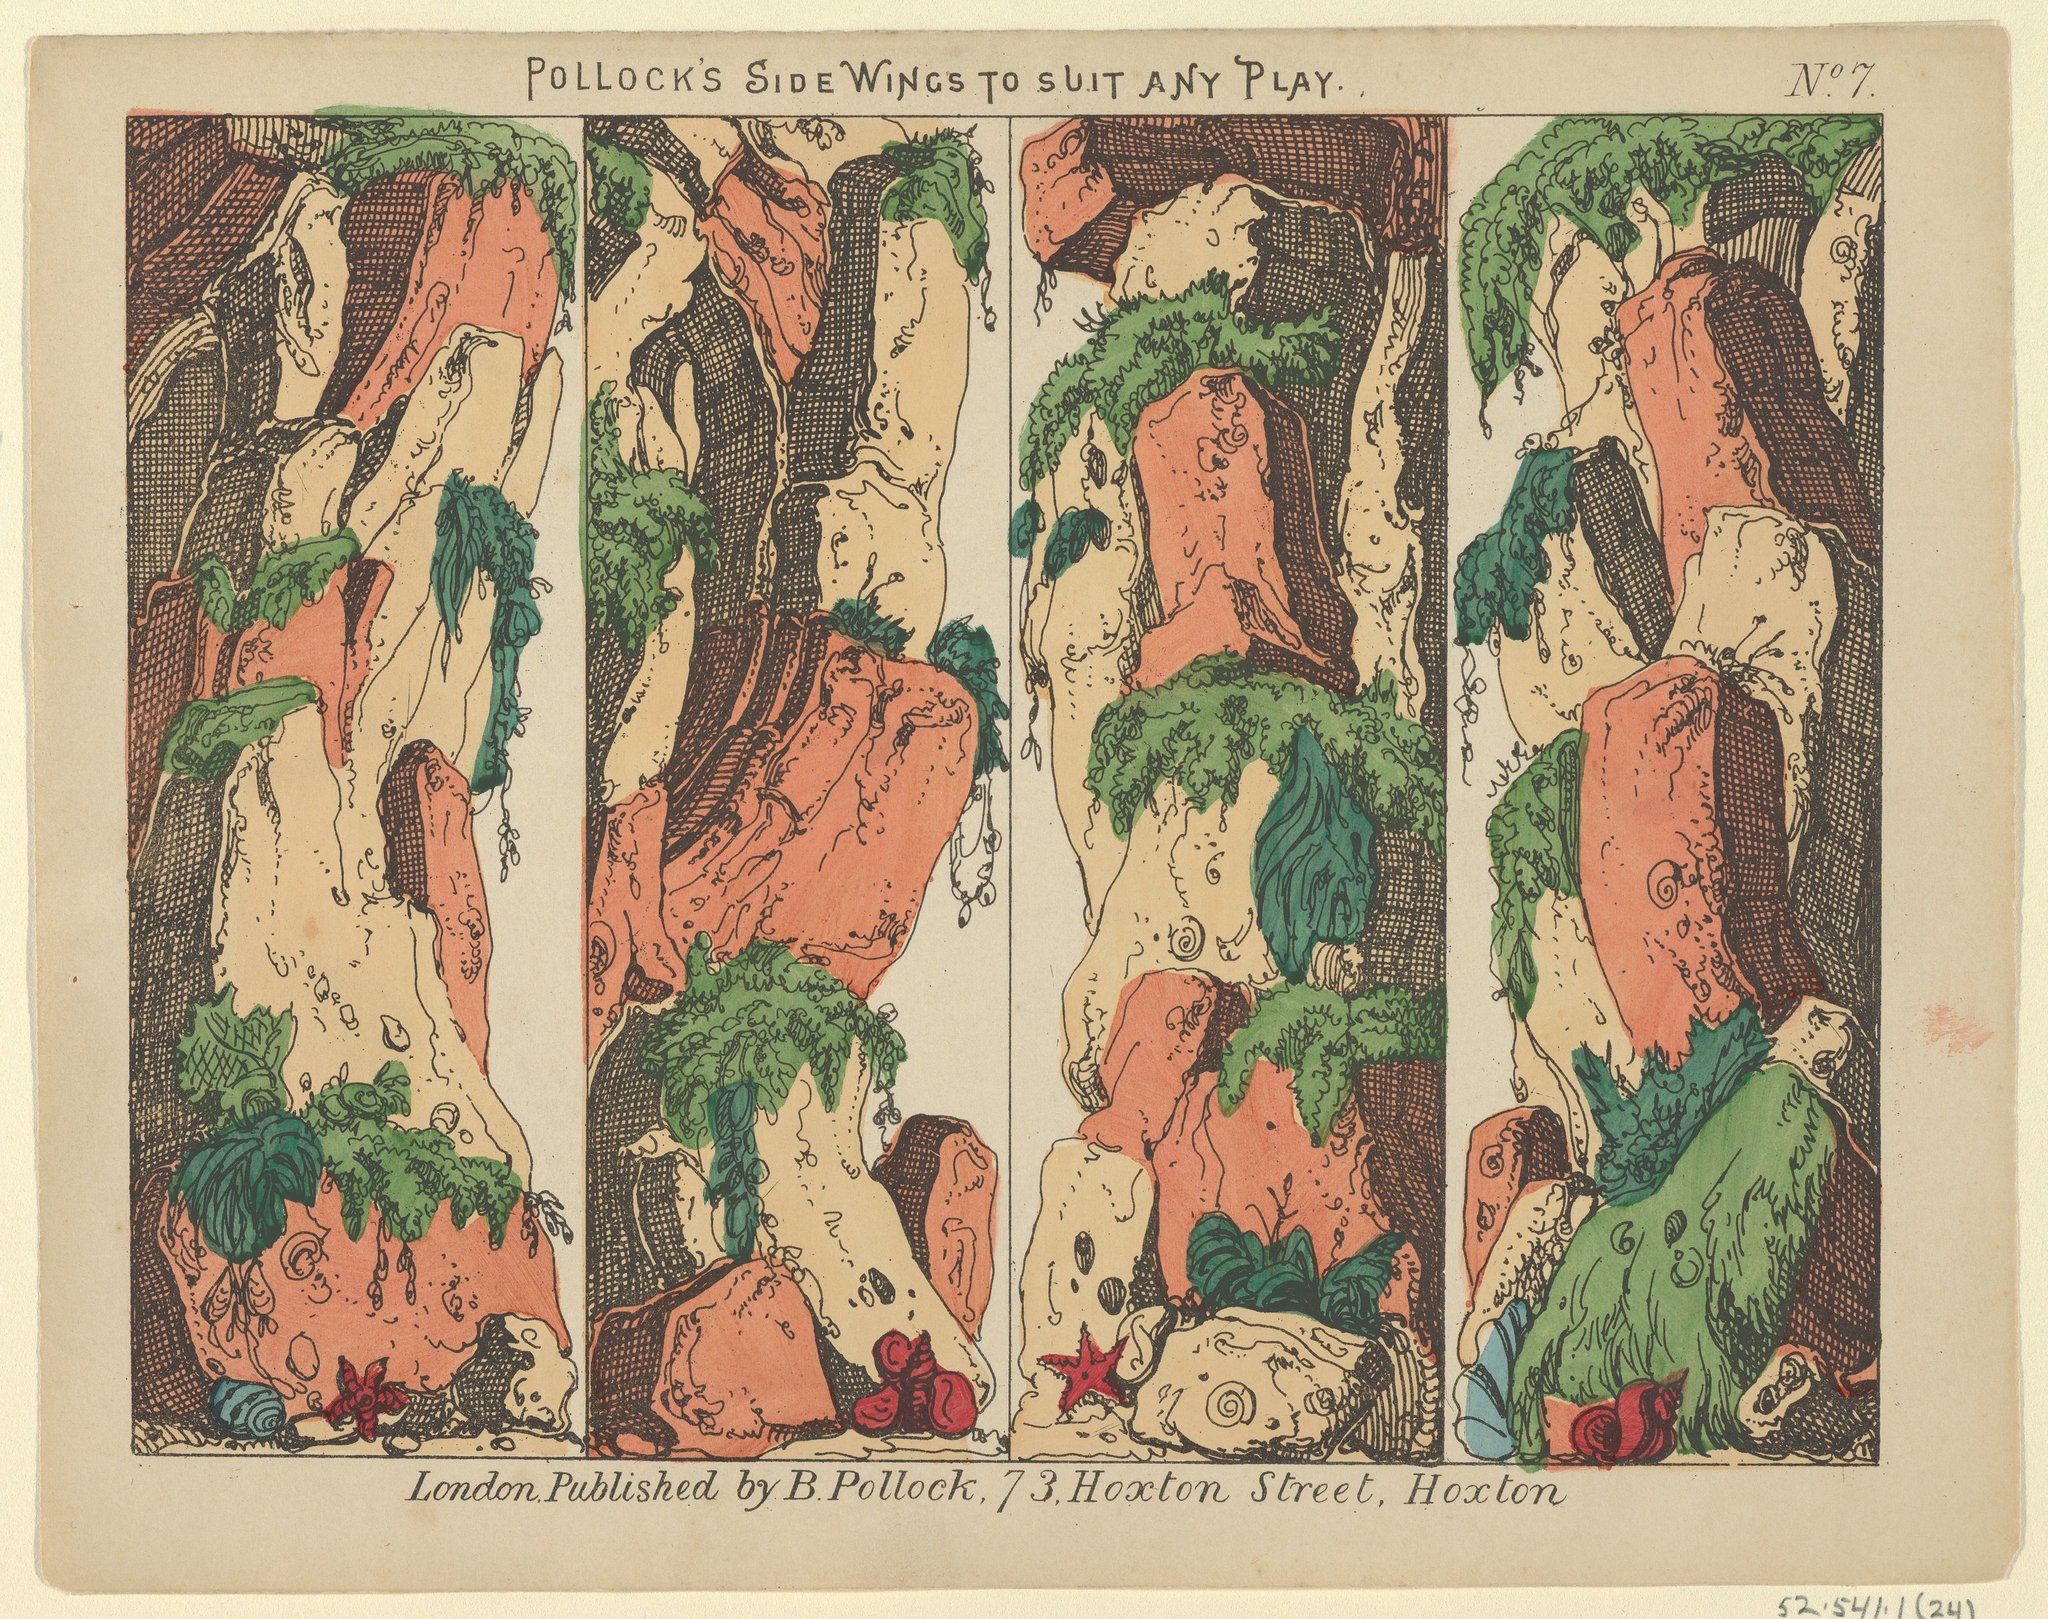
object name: print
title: Side Wings to Suit any Play, Plate 7 for a Toy Theater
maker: benjamin pollock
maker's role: publisher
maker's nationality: british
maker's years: 1857-1937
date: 1870-1890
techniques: lithograph